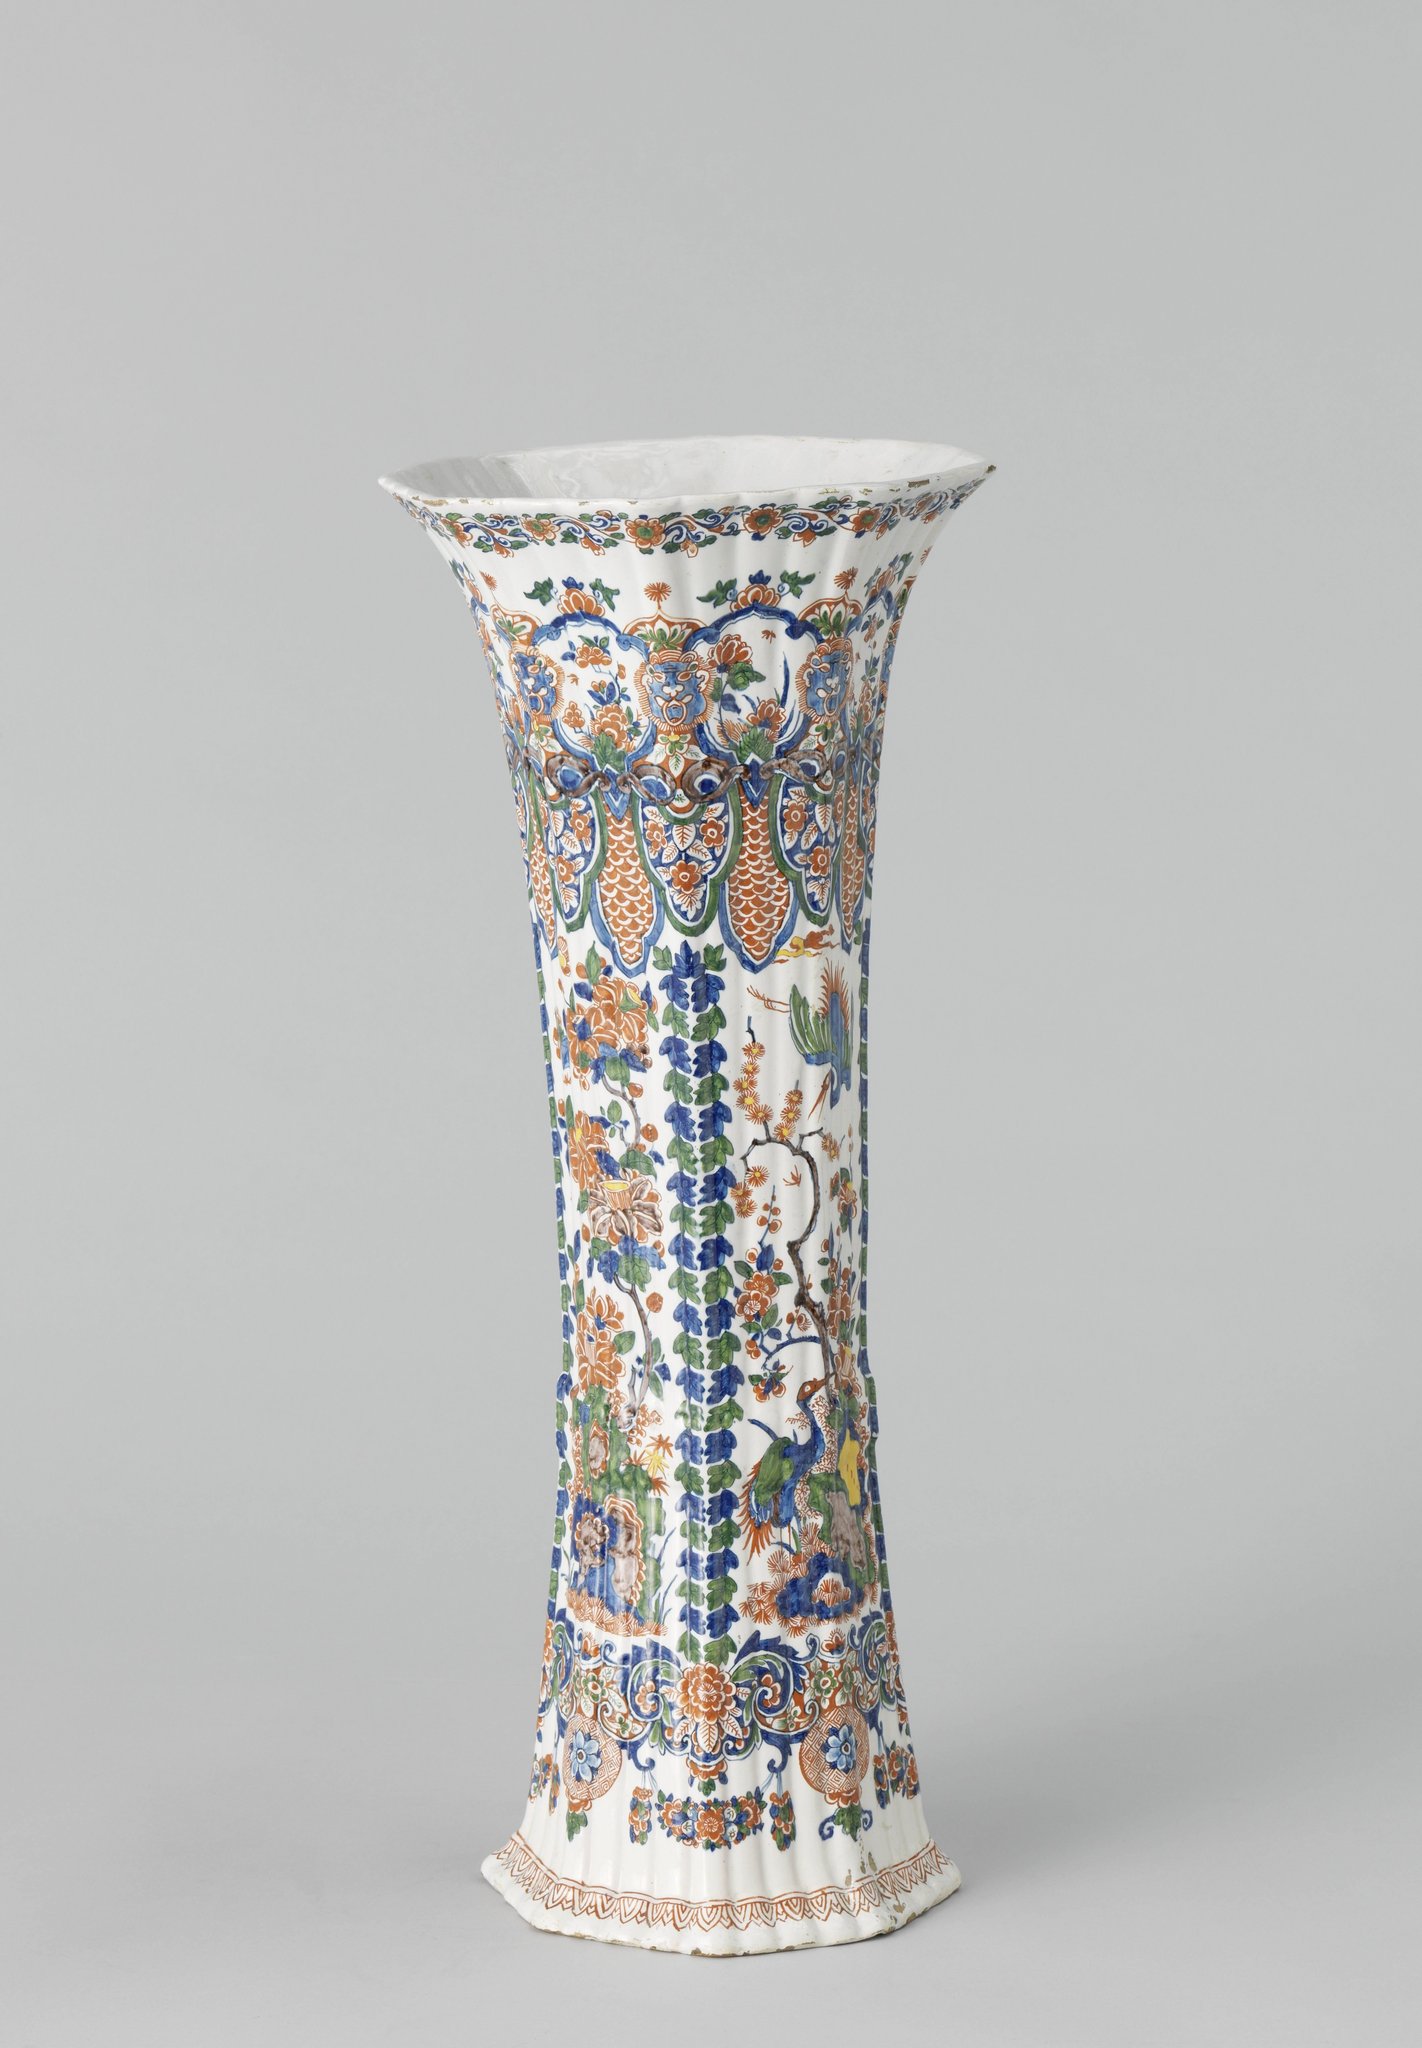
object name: vase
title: Vaas van veelkleurig beschilderde faience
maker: Anonymous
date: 1695-1715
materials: earthenware, paint, glaze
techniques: firing, polychromy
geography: delft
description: Geribde, achthoekige veelkleurig beschilderde vaas. Onderdeel van een kaststel bestaande uit vijf delen.